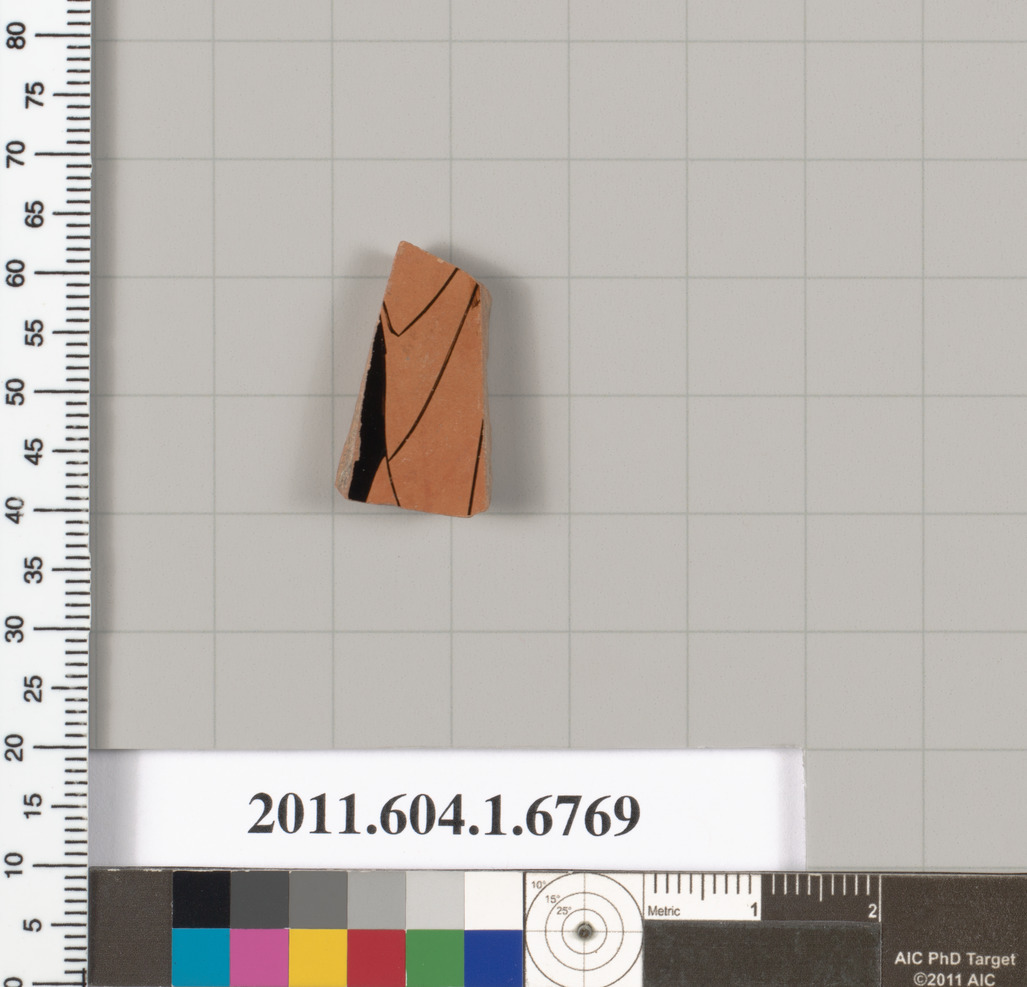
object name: kylix fragment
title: Terracotta fragment of a kylix (drinking cup)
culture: greek, attic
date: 490-470 BCE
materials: terracotta